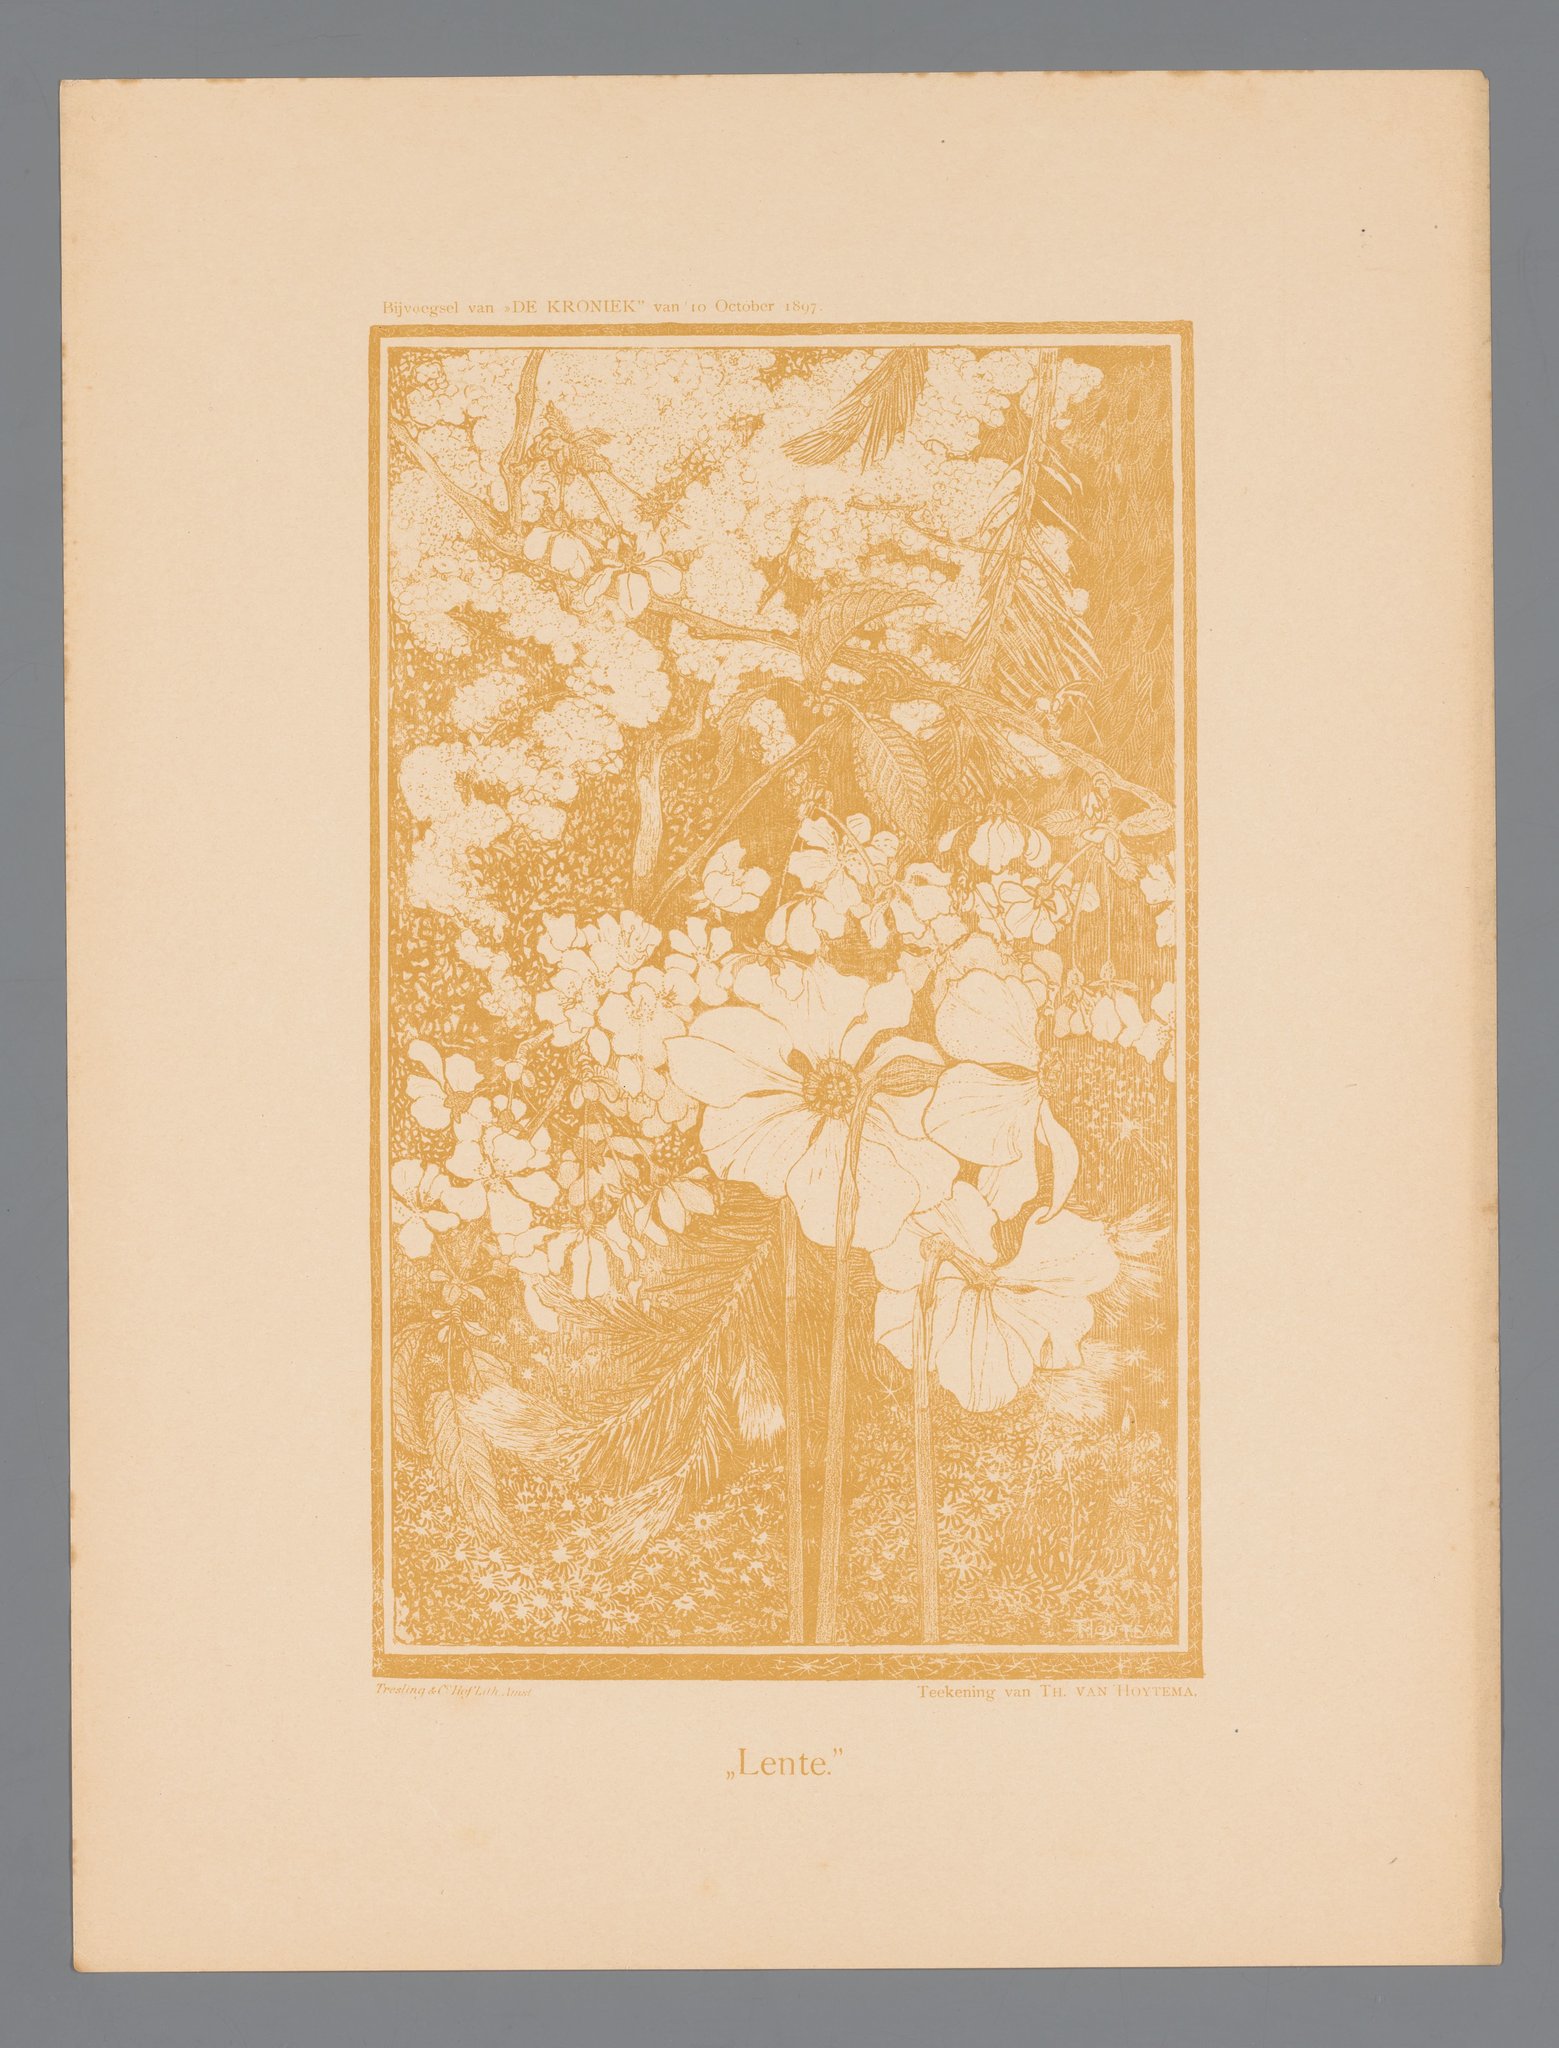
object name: print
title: Lente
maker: theo van hoytema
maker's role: draughtsman, painter, print maker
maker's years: 1863-1917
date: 1897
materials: paper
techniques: lithograph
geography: amsterdam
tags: flowers, spring, 'ver'; 'primavera' (ripa)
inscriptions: date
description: Prent uit het bijvoegsel van: De Kroniek 3 (1897), 10 oktober 1897.